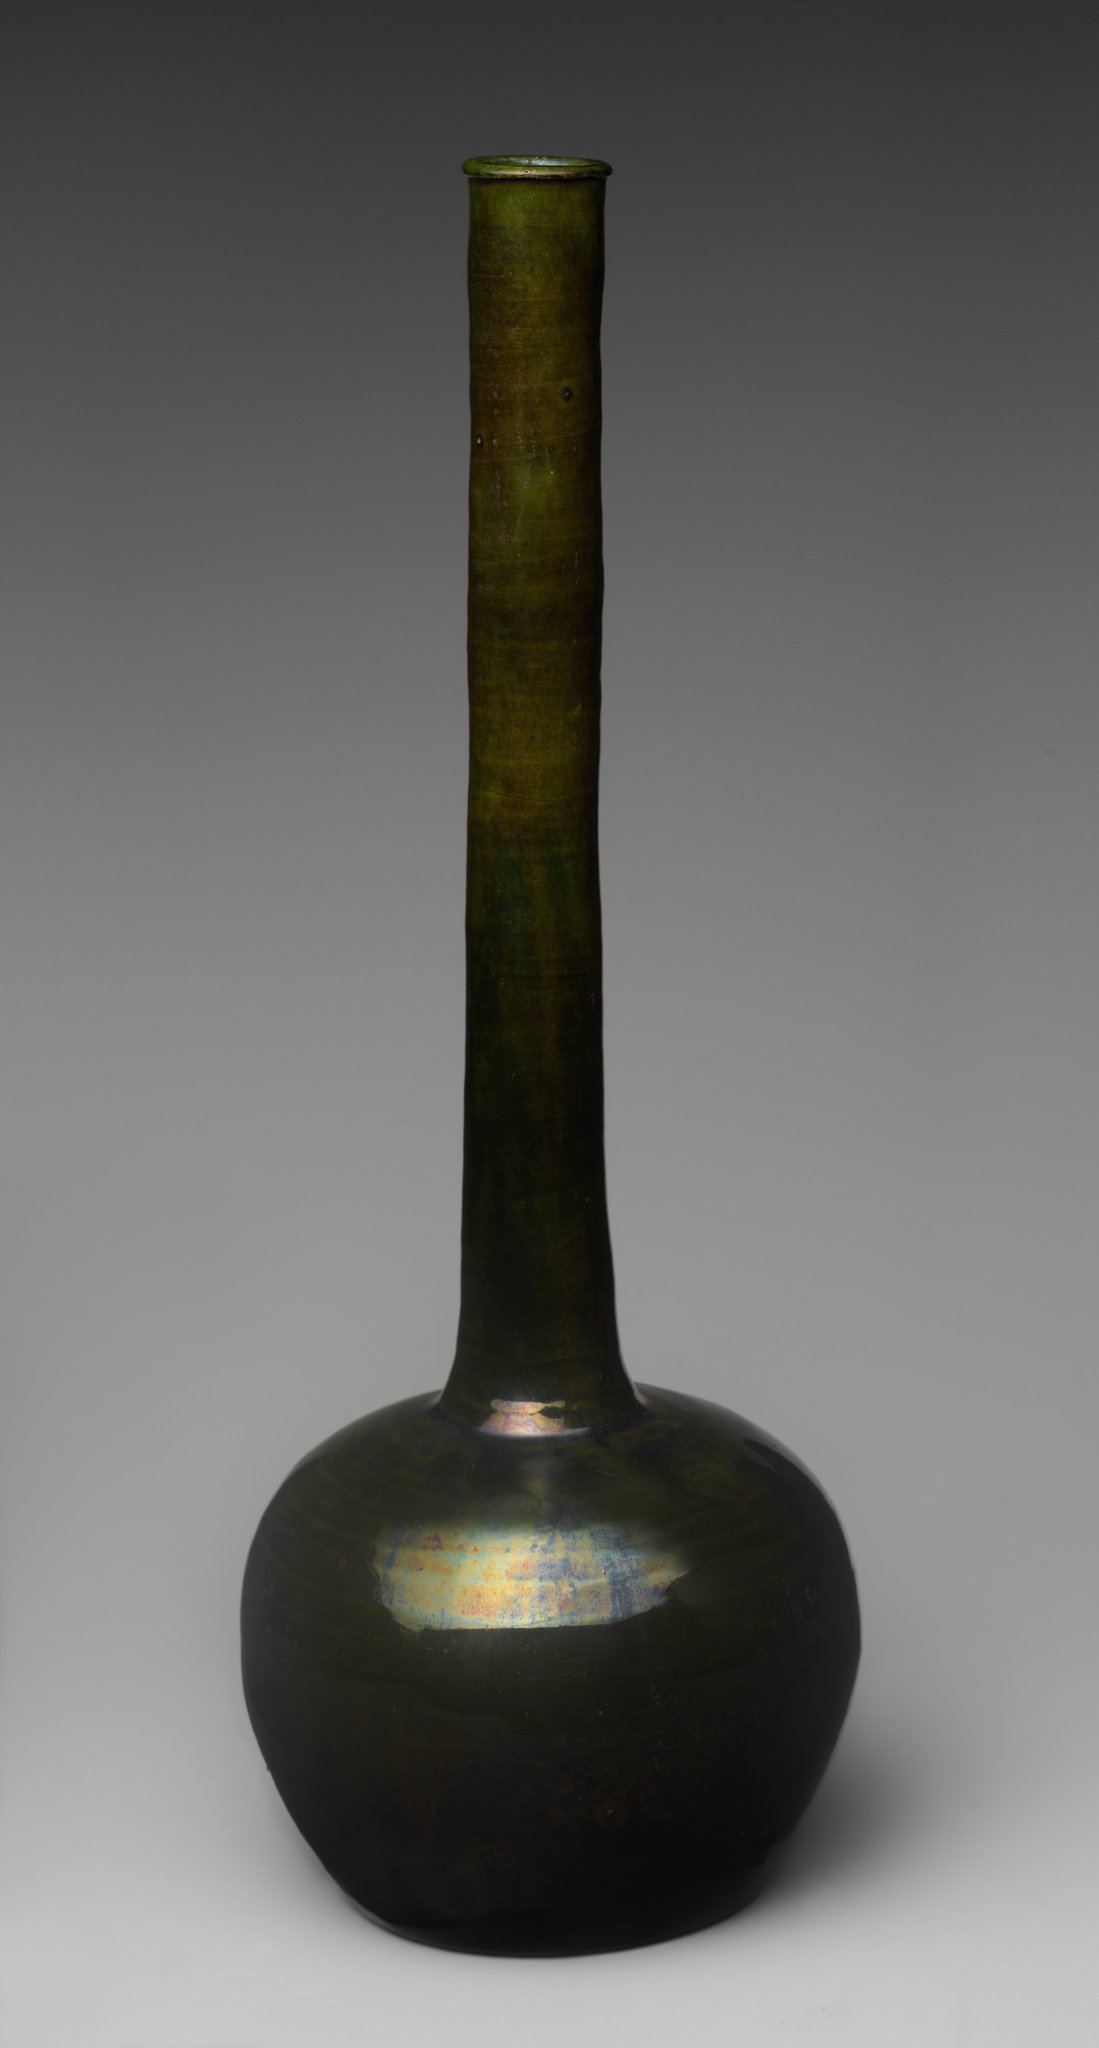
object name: bottle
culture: japanese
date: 1830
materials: glaze, pottery